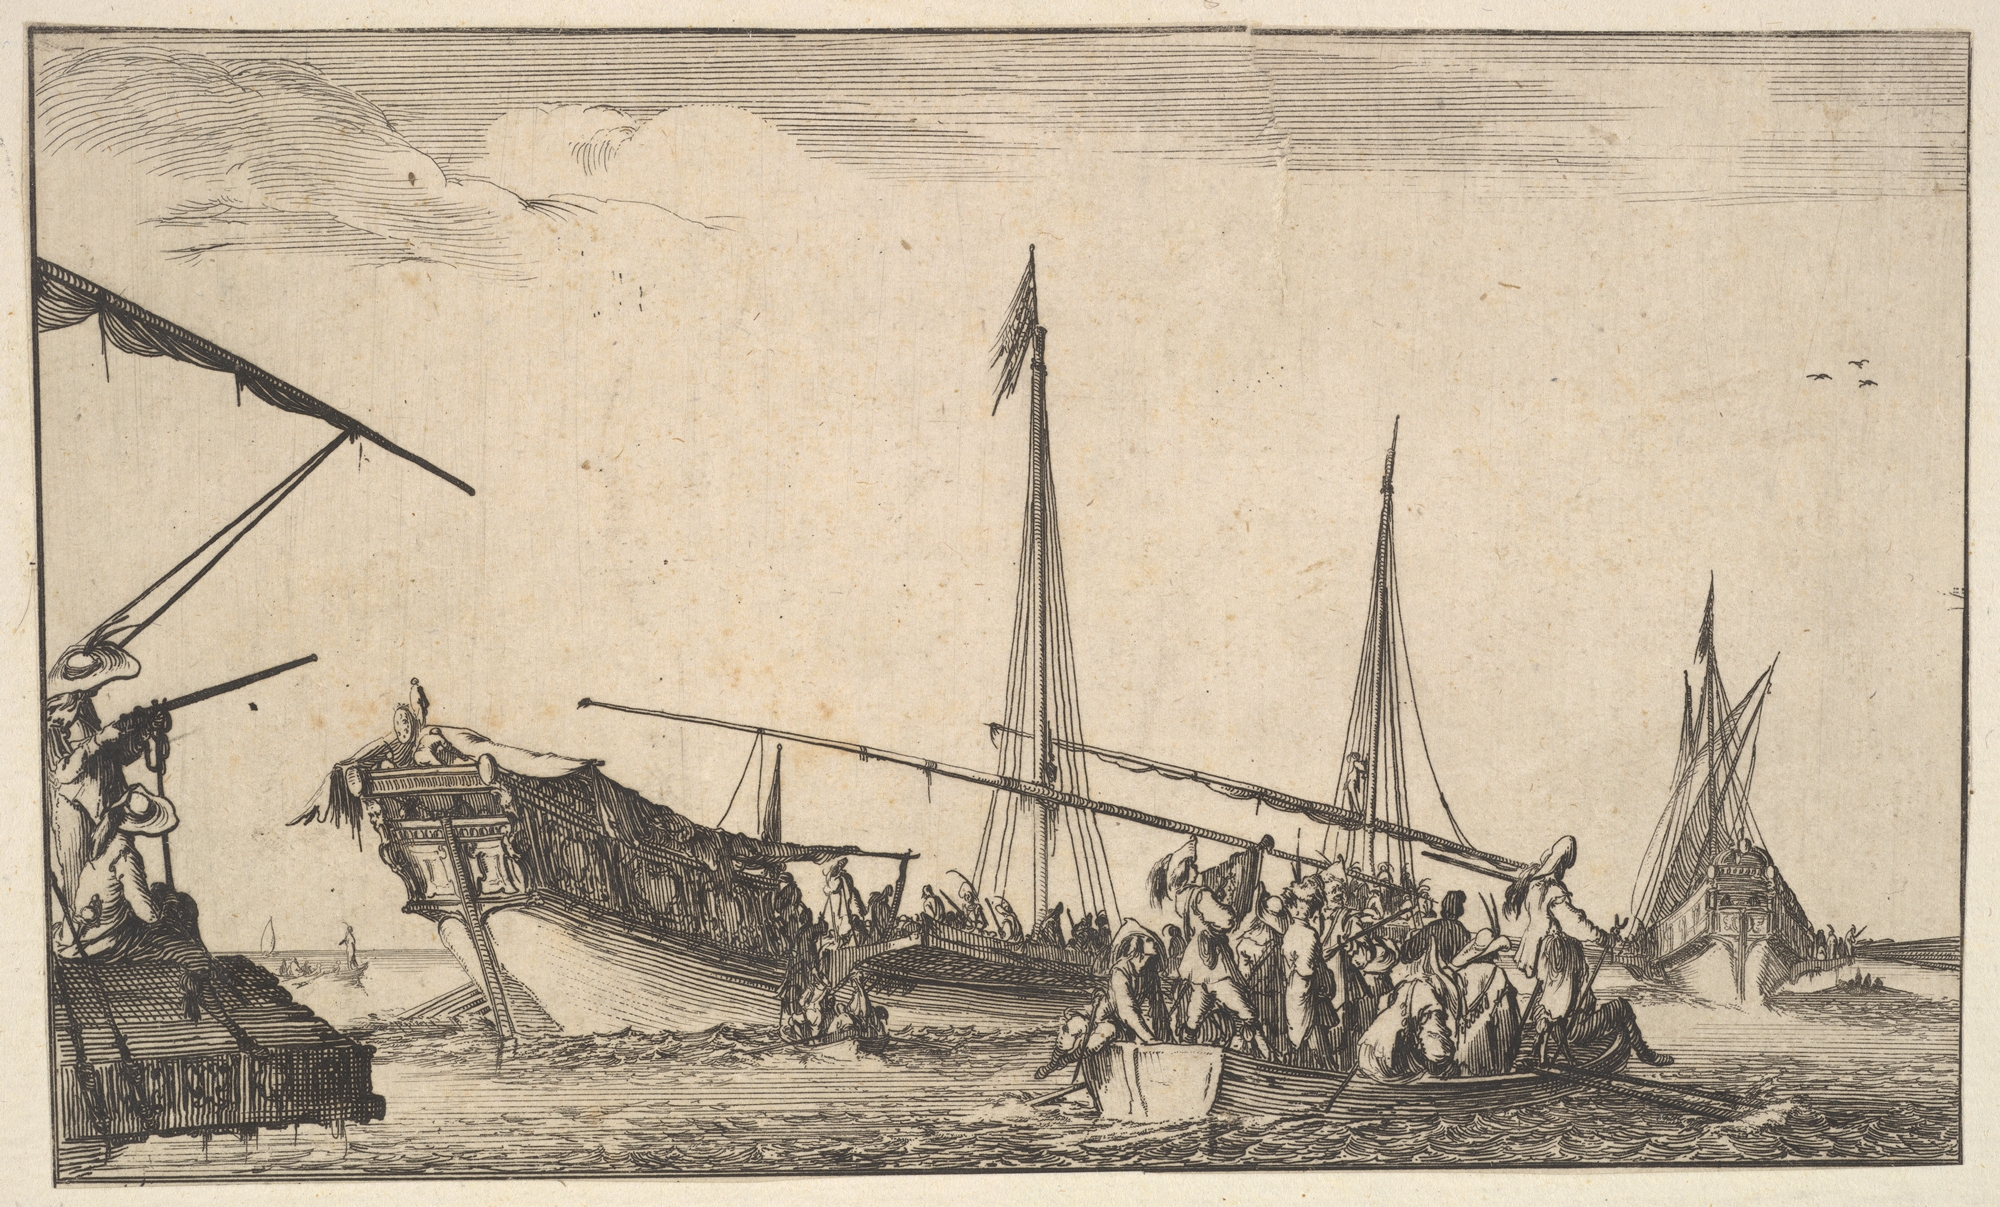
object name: print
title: A rowboat full of men at right, a ship with men descending into a rowboat behind to left, two men with a shotgun on a ship to left, another ship to far right in the background, from "Set of eight nautical landscapes" (Suite de huit Marines)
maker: stefano della bella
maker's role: artist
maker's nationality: italian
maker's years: 1610-1664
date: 1639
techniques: etching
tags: boats,ships